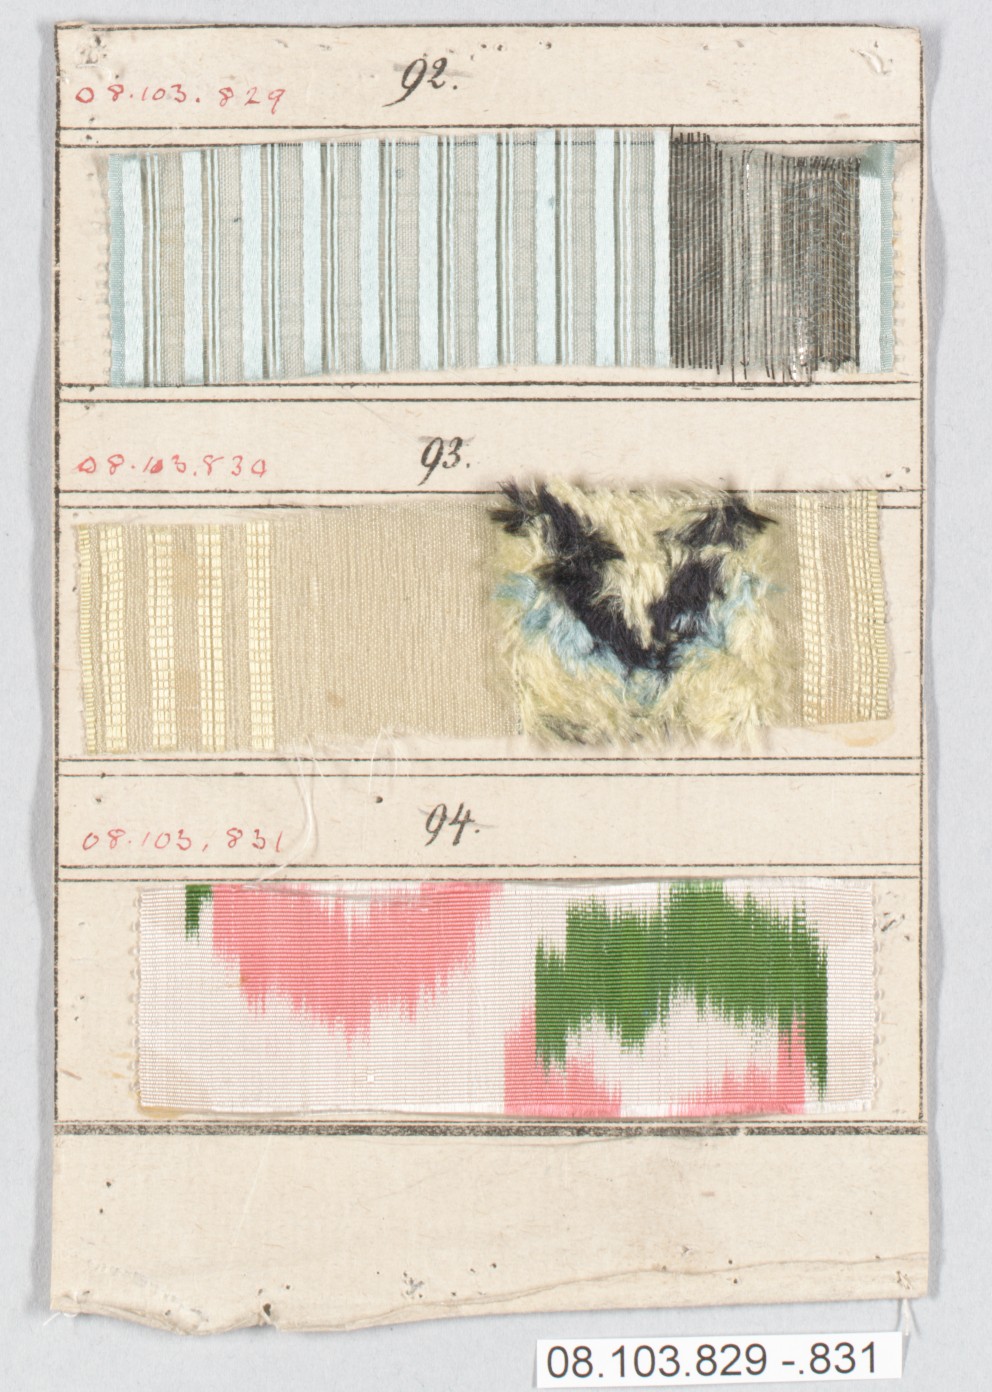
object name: ribbon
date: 1701-1900